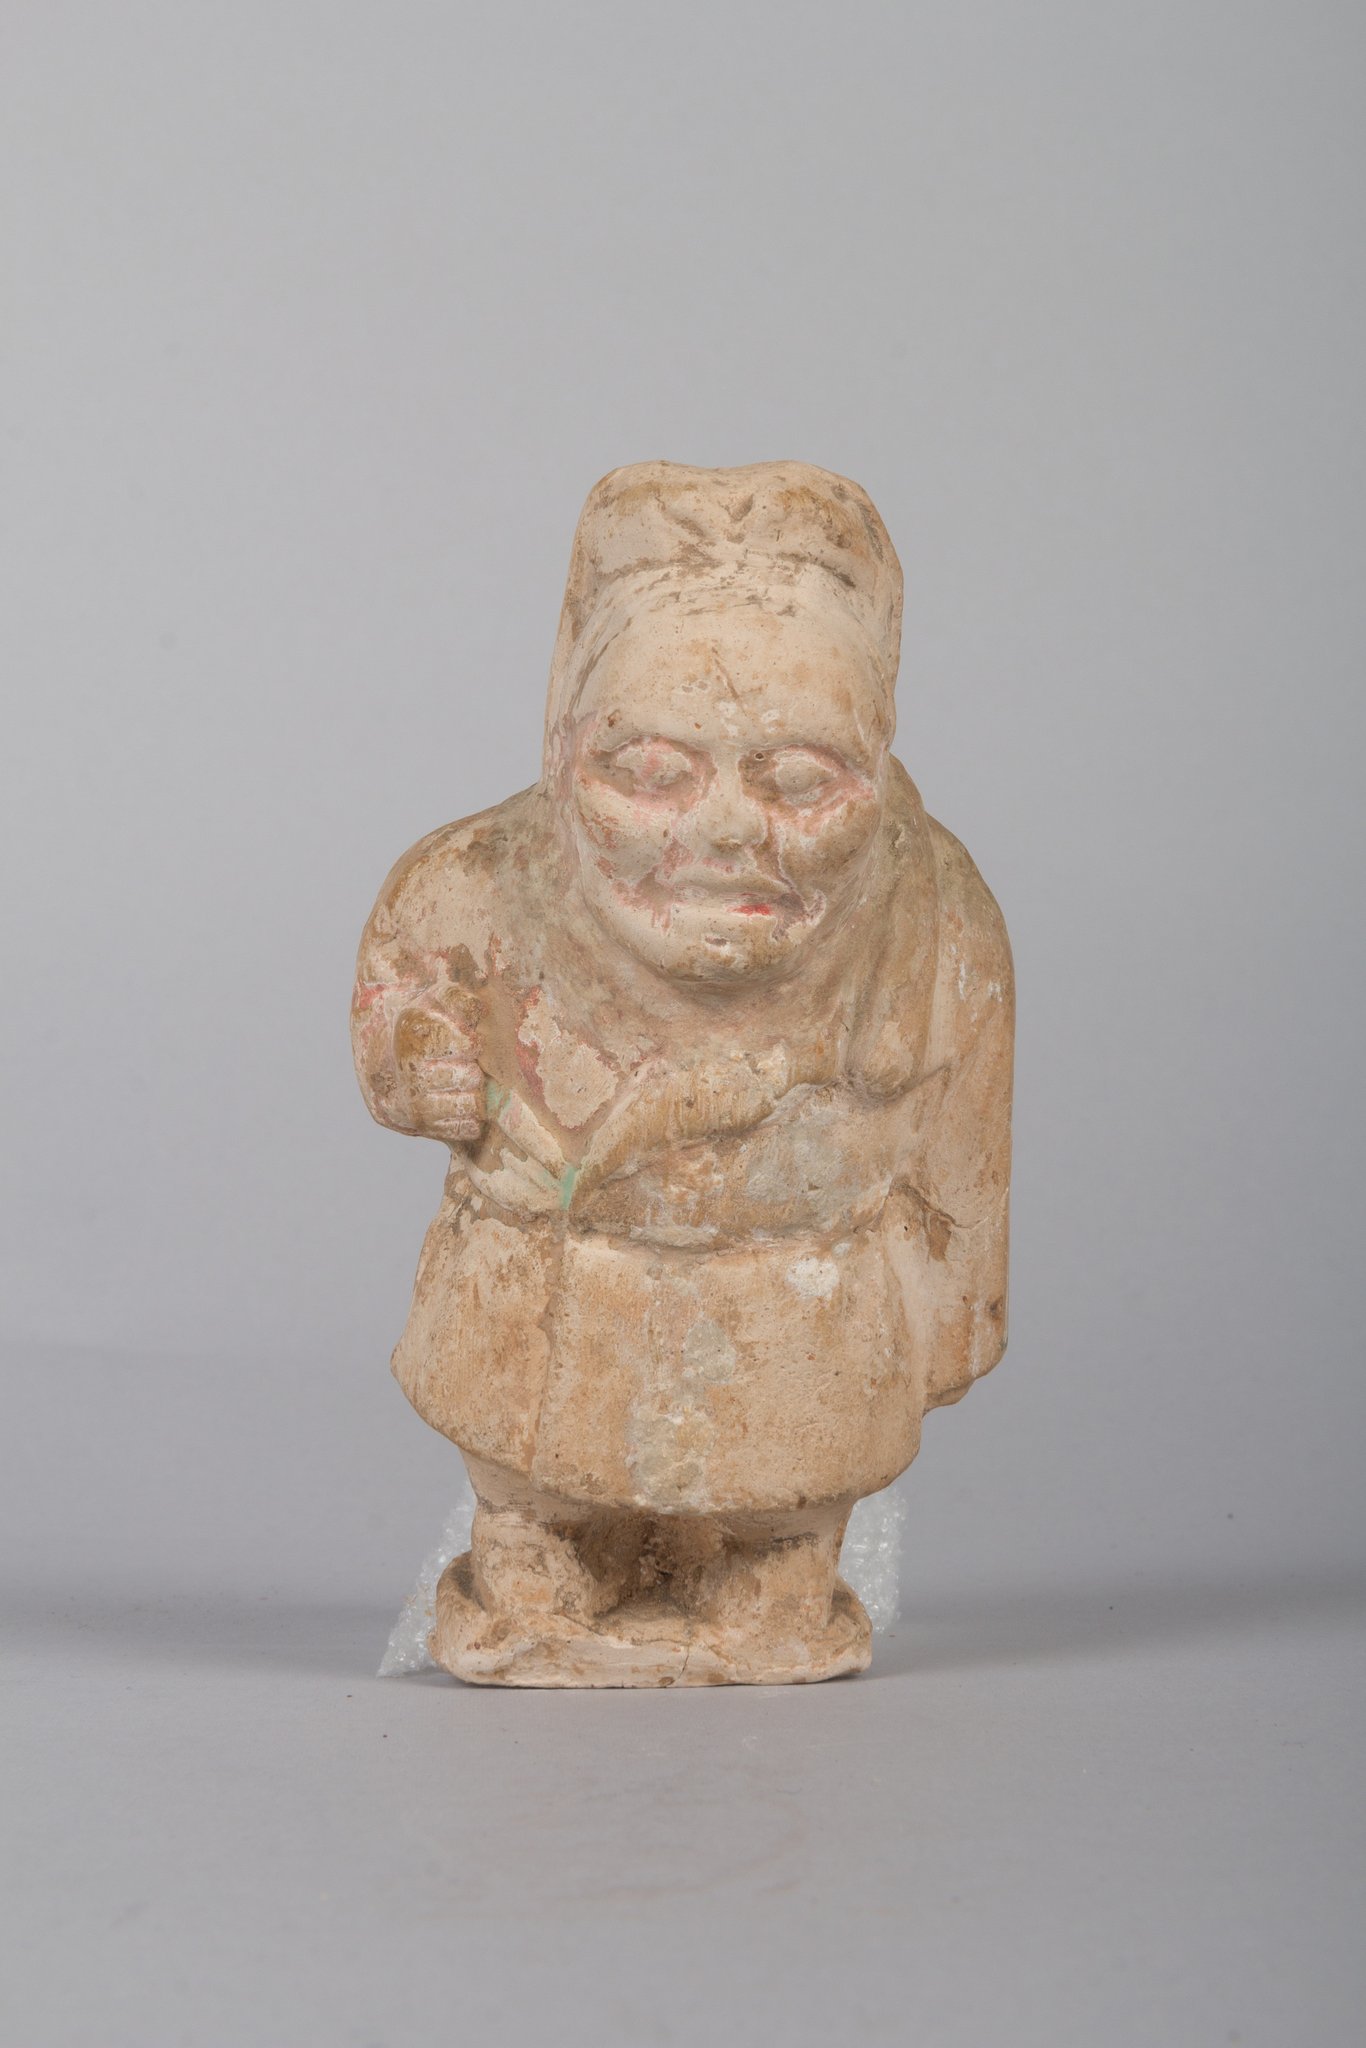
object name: figure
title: Dwarf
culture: chinese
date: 601-800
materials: earthenware